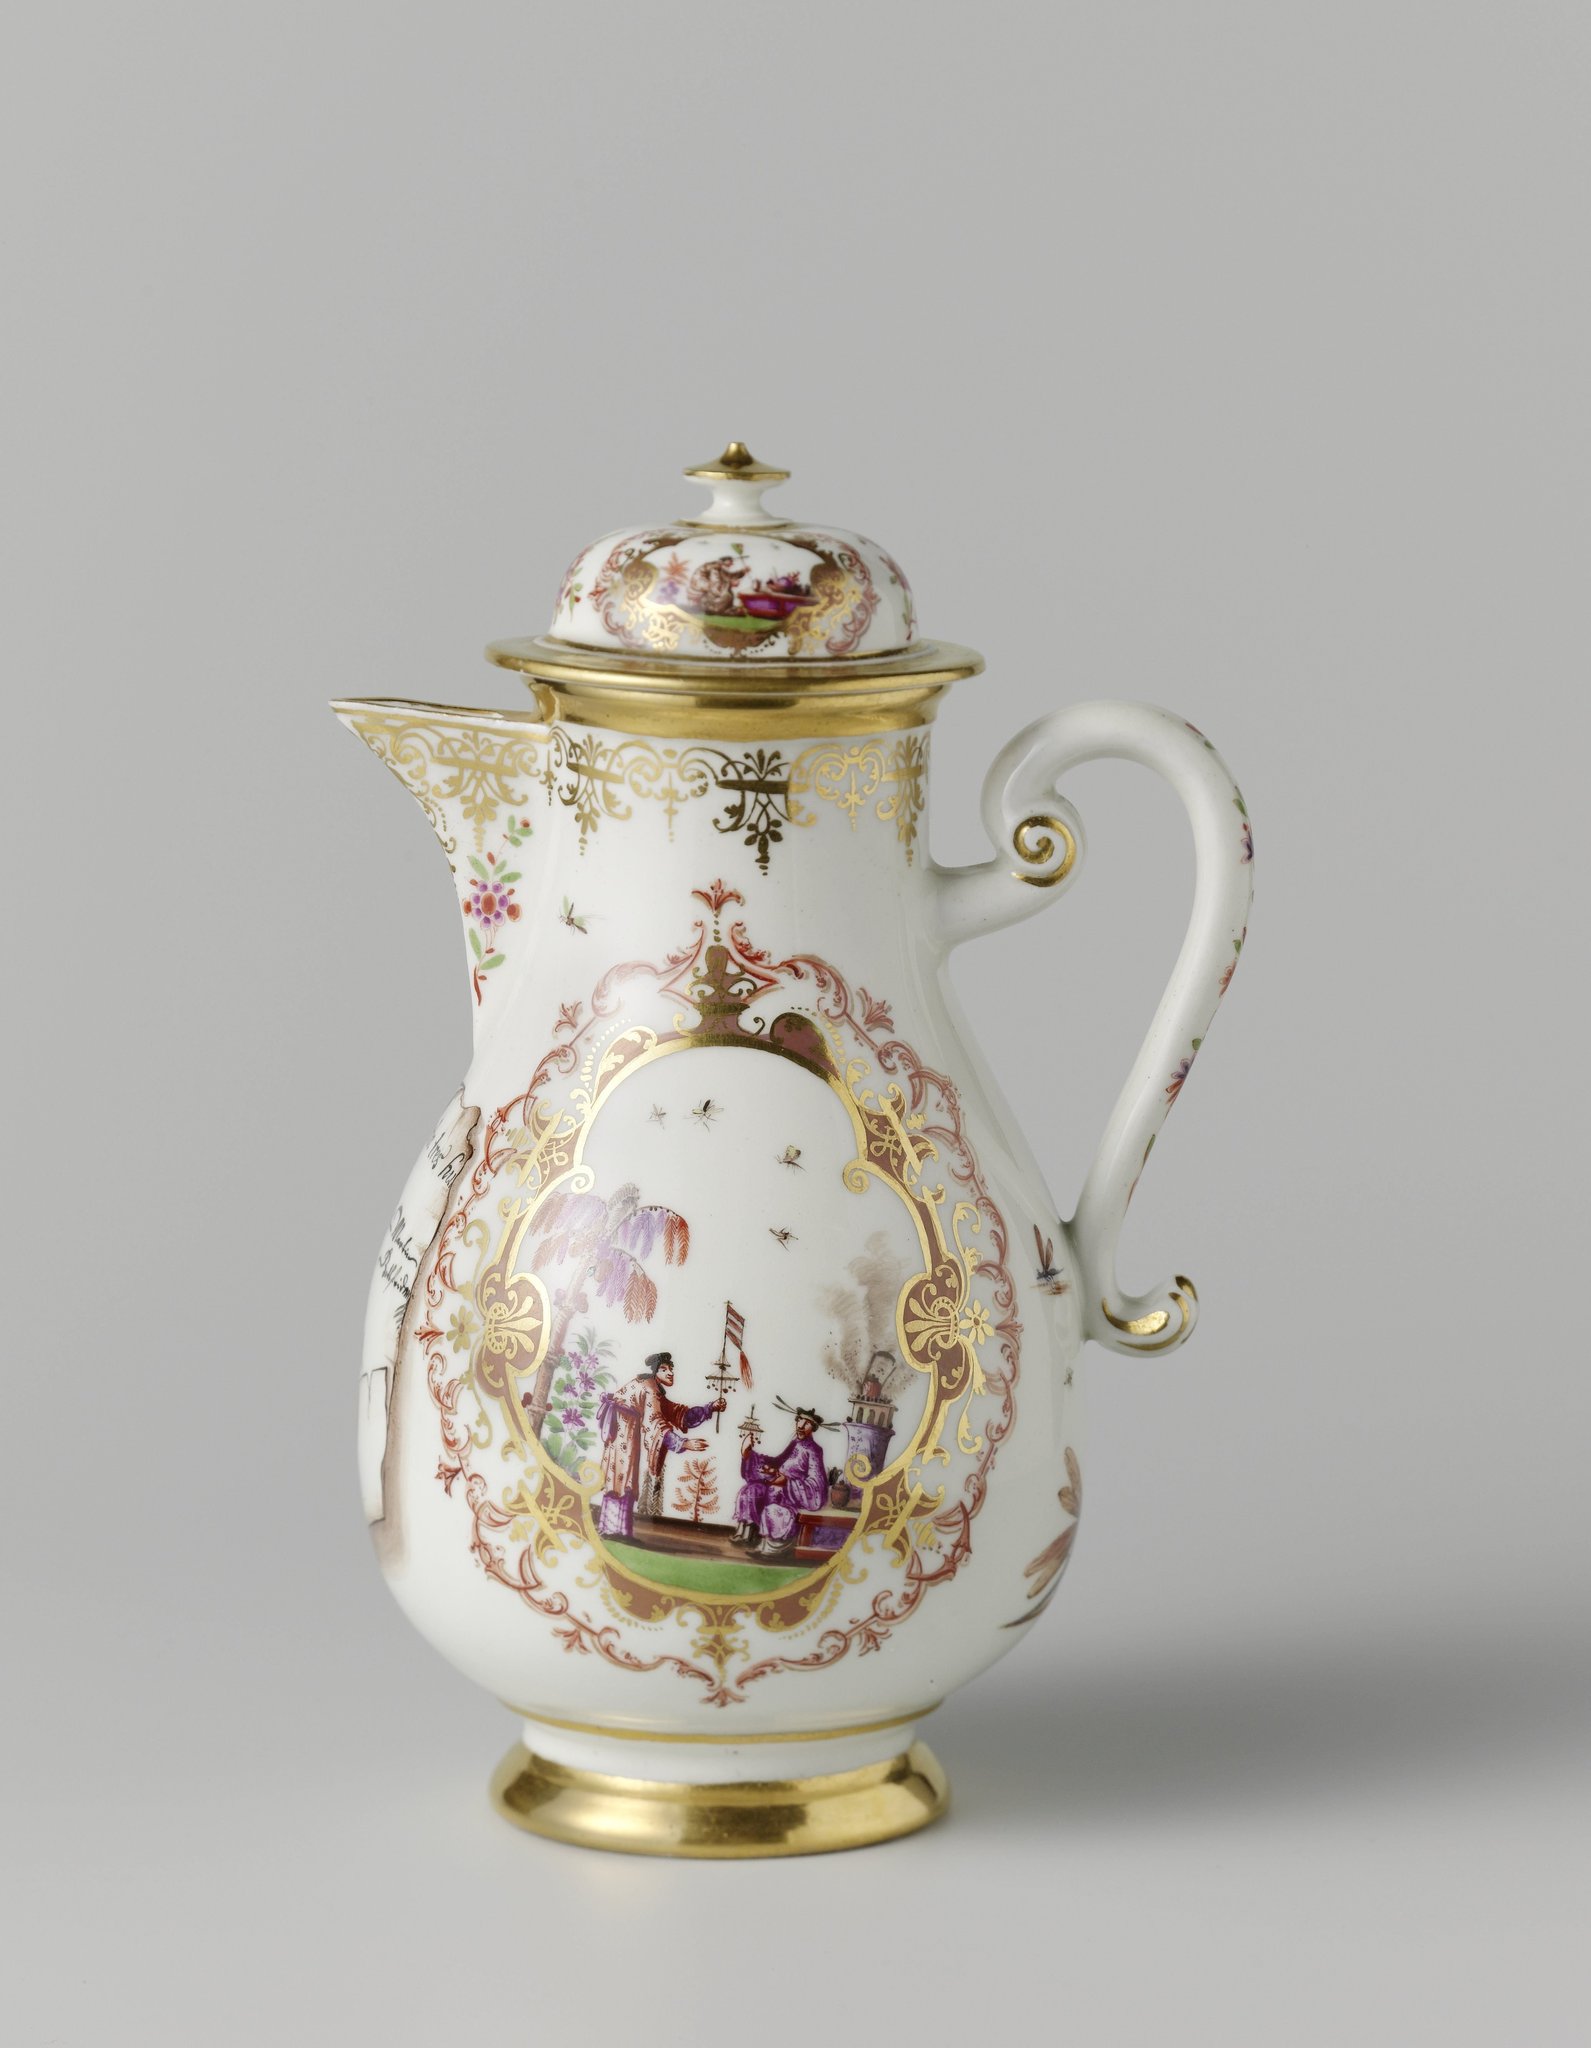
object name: coffee pot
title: Koffiekan met deksel, veelkleurig beschilderd met chinoiserieën en een trompe l'oeuil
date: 1729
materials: porcelain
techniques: painted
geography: meissen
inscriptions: label: ‘SAMMLUNG / Dr. FRANZ OPPENHEIMER’, number: ‘144.’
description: Coffee pot. Porcelain. Meissen, 1729.